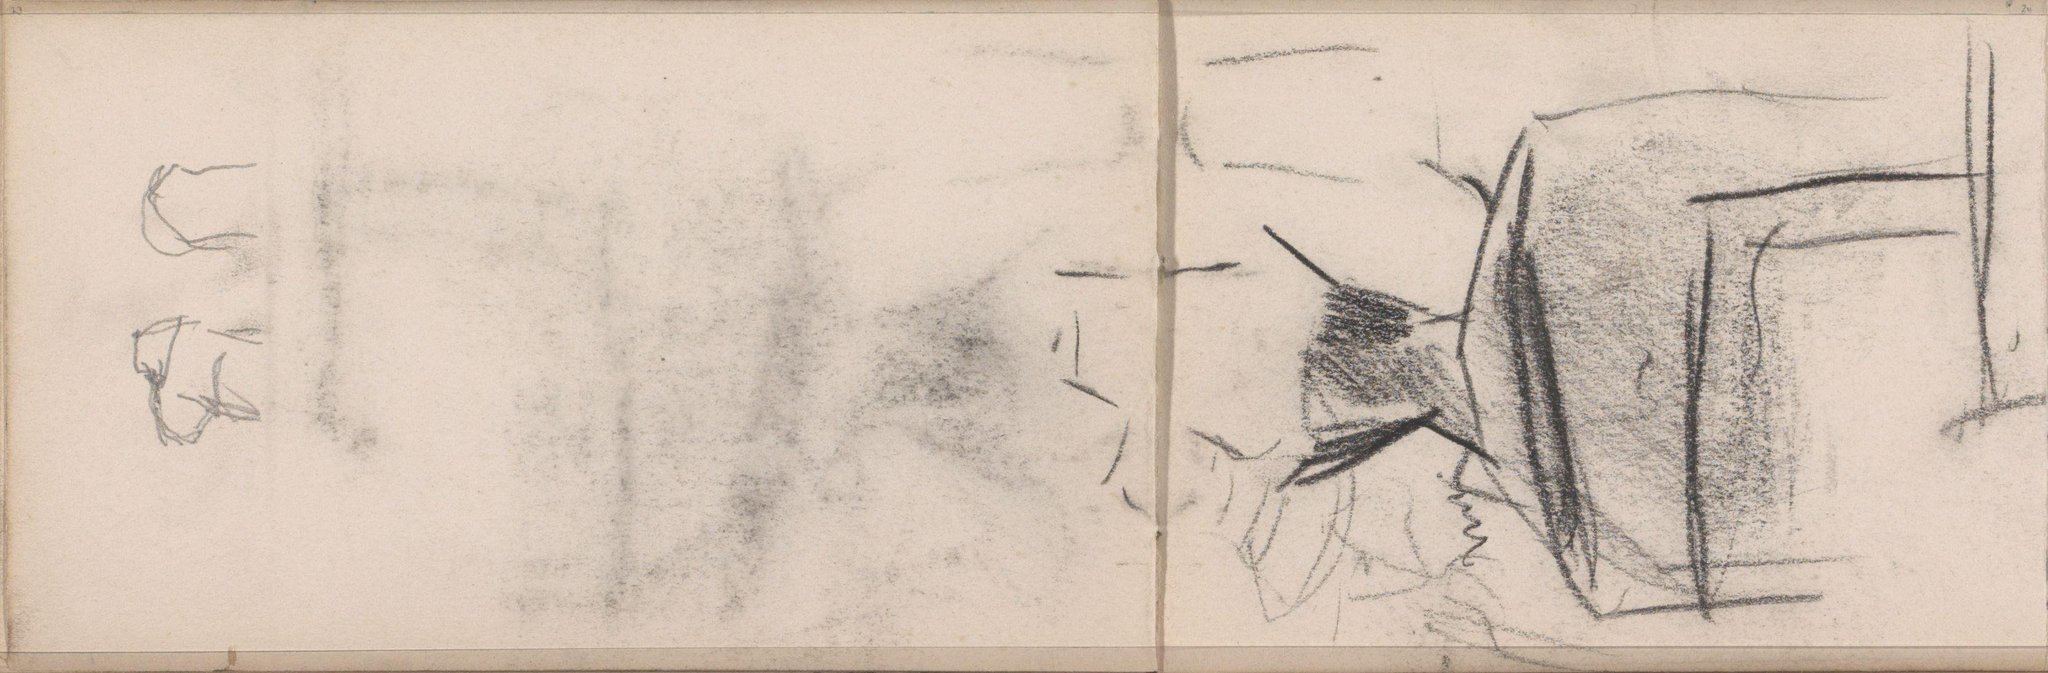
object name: sketchbook leaf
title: Schoenen en een man, op de rug gezien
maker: george hendrik breitner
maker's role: draughtsman, painter, print maker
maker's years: 1857-1923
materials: chalk, paper, pencil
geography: amsterdam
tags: adult man (+ back view), shoes, sandals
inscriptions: annotation: ‘[...]’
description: Pagina 23 en pagina 24 uit een schetsboek met 32 bladen.